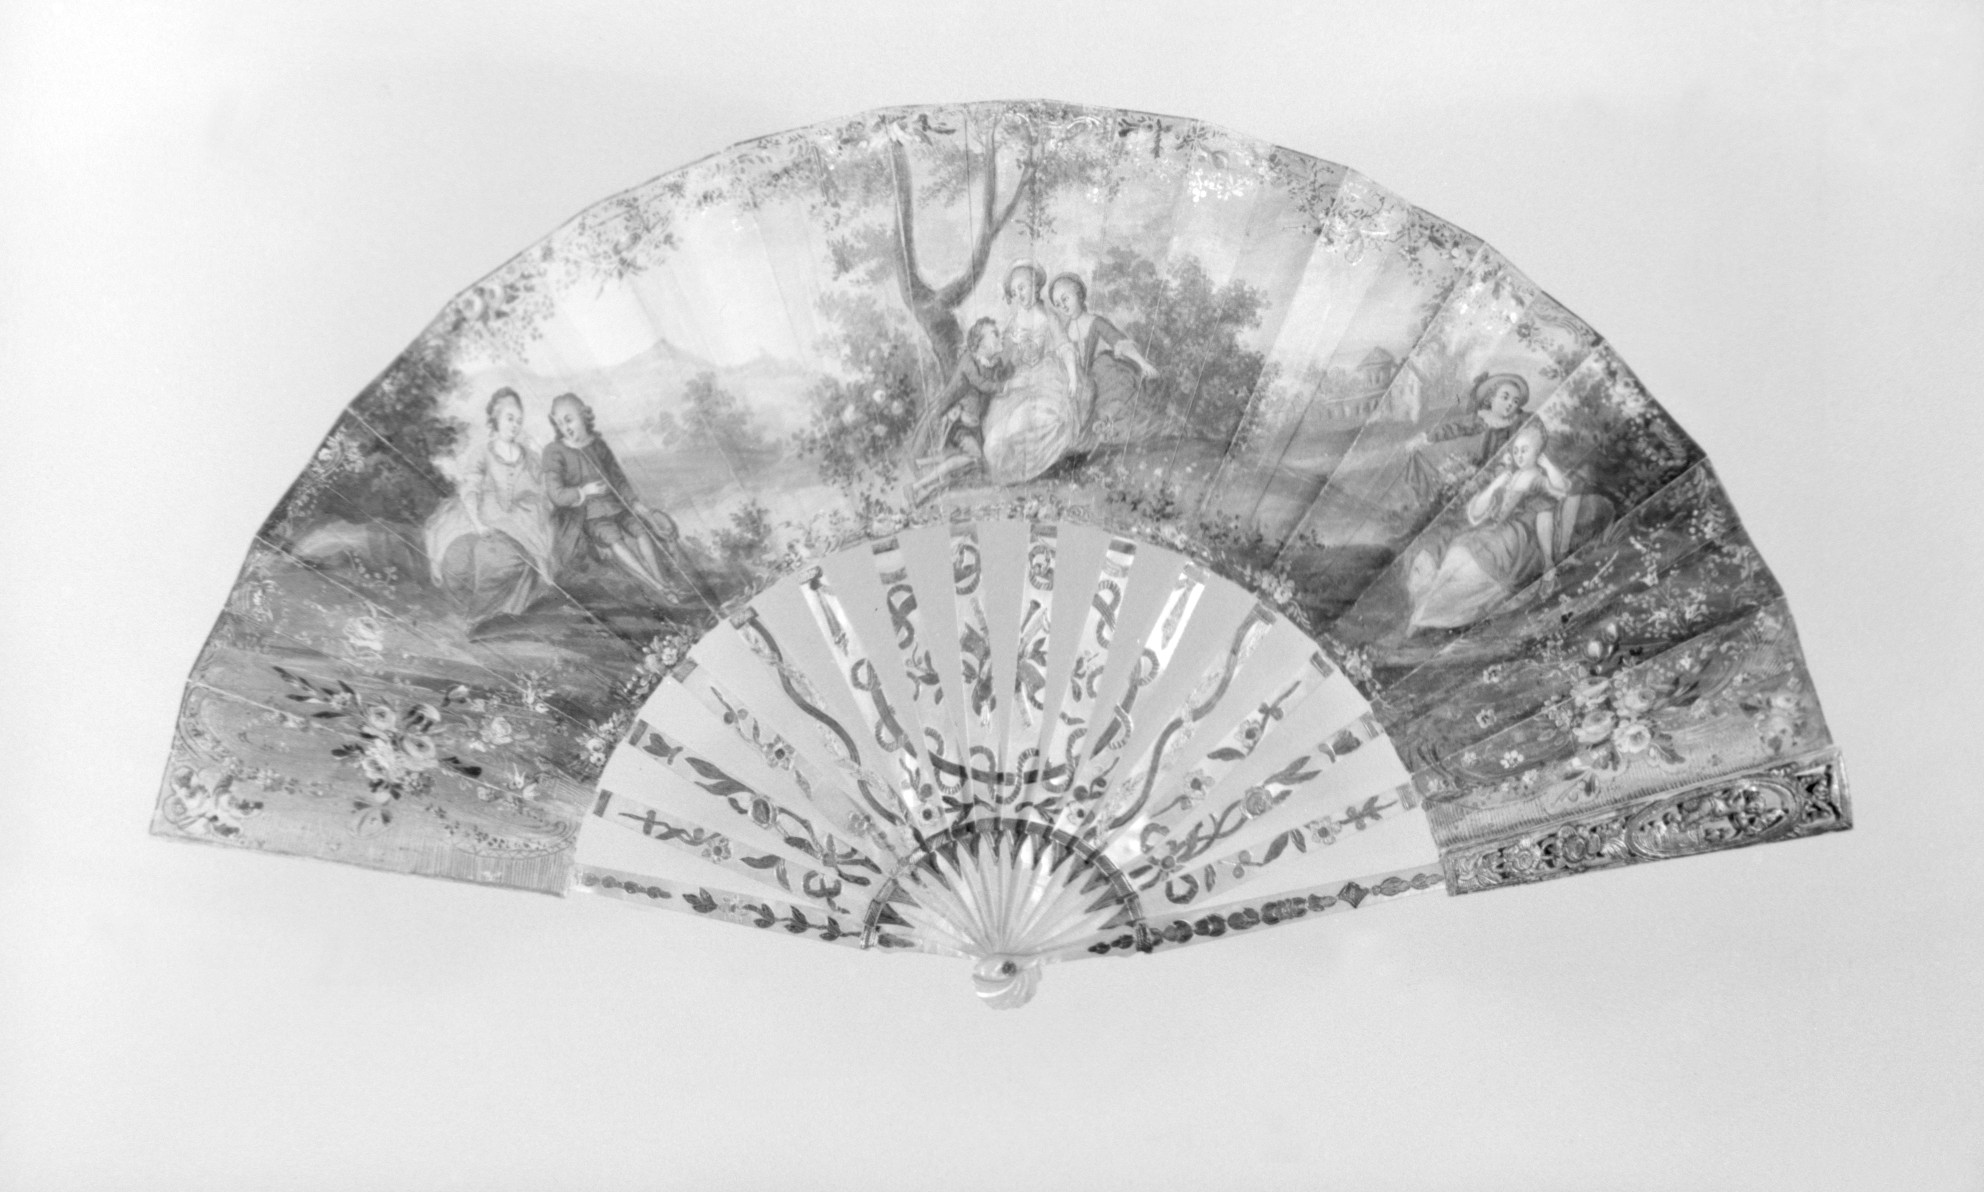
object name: fan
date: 1701-1800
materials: mother of pearl, parchment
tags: men,women